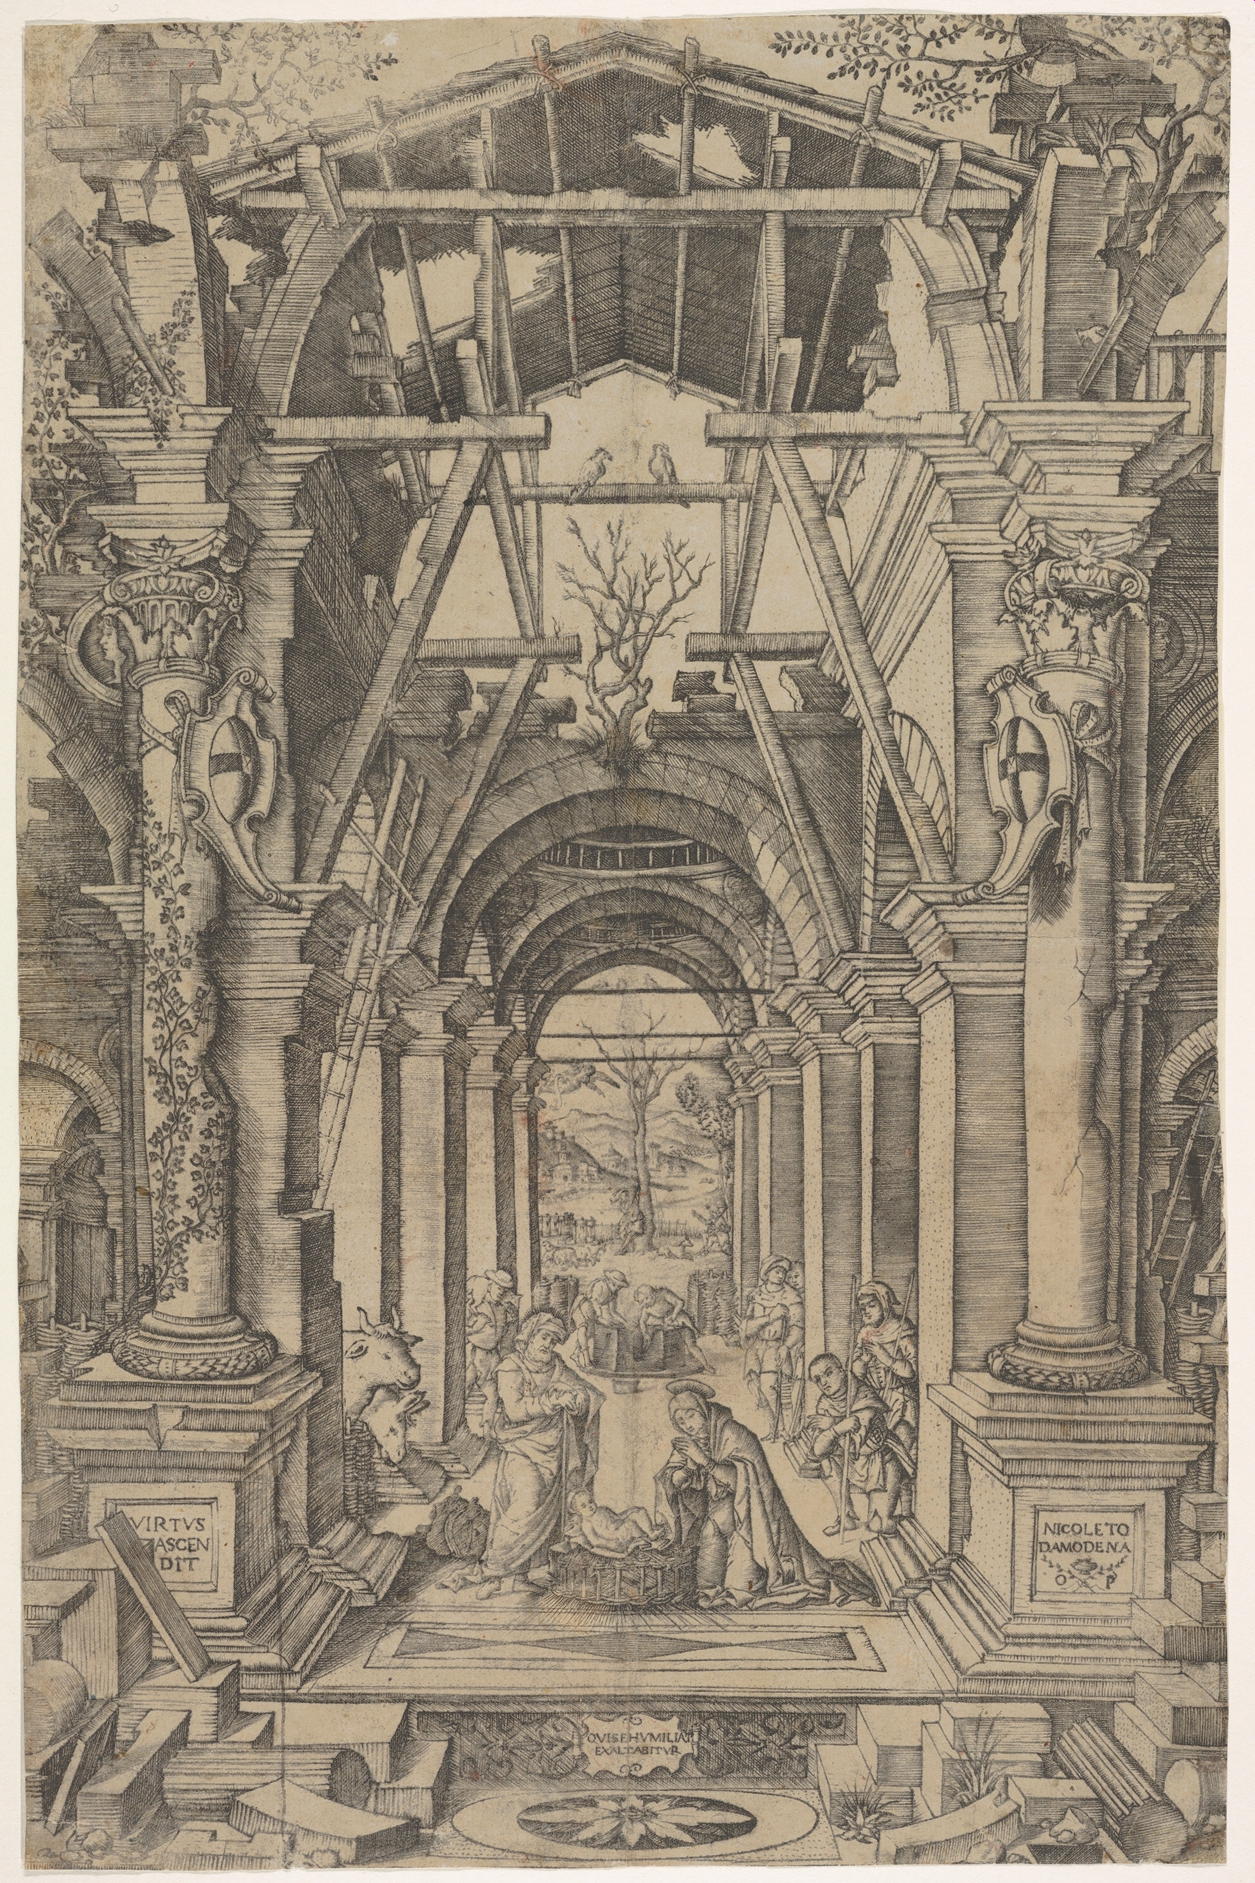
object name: print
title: The Nativity and Adoration of the Shepherds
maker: nicoletto da modena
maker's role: artist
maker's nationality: italian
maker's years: 1500-1520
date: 1501-1533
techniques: engraving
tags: adoration of the shepherds,nativity